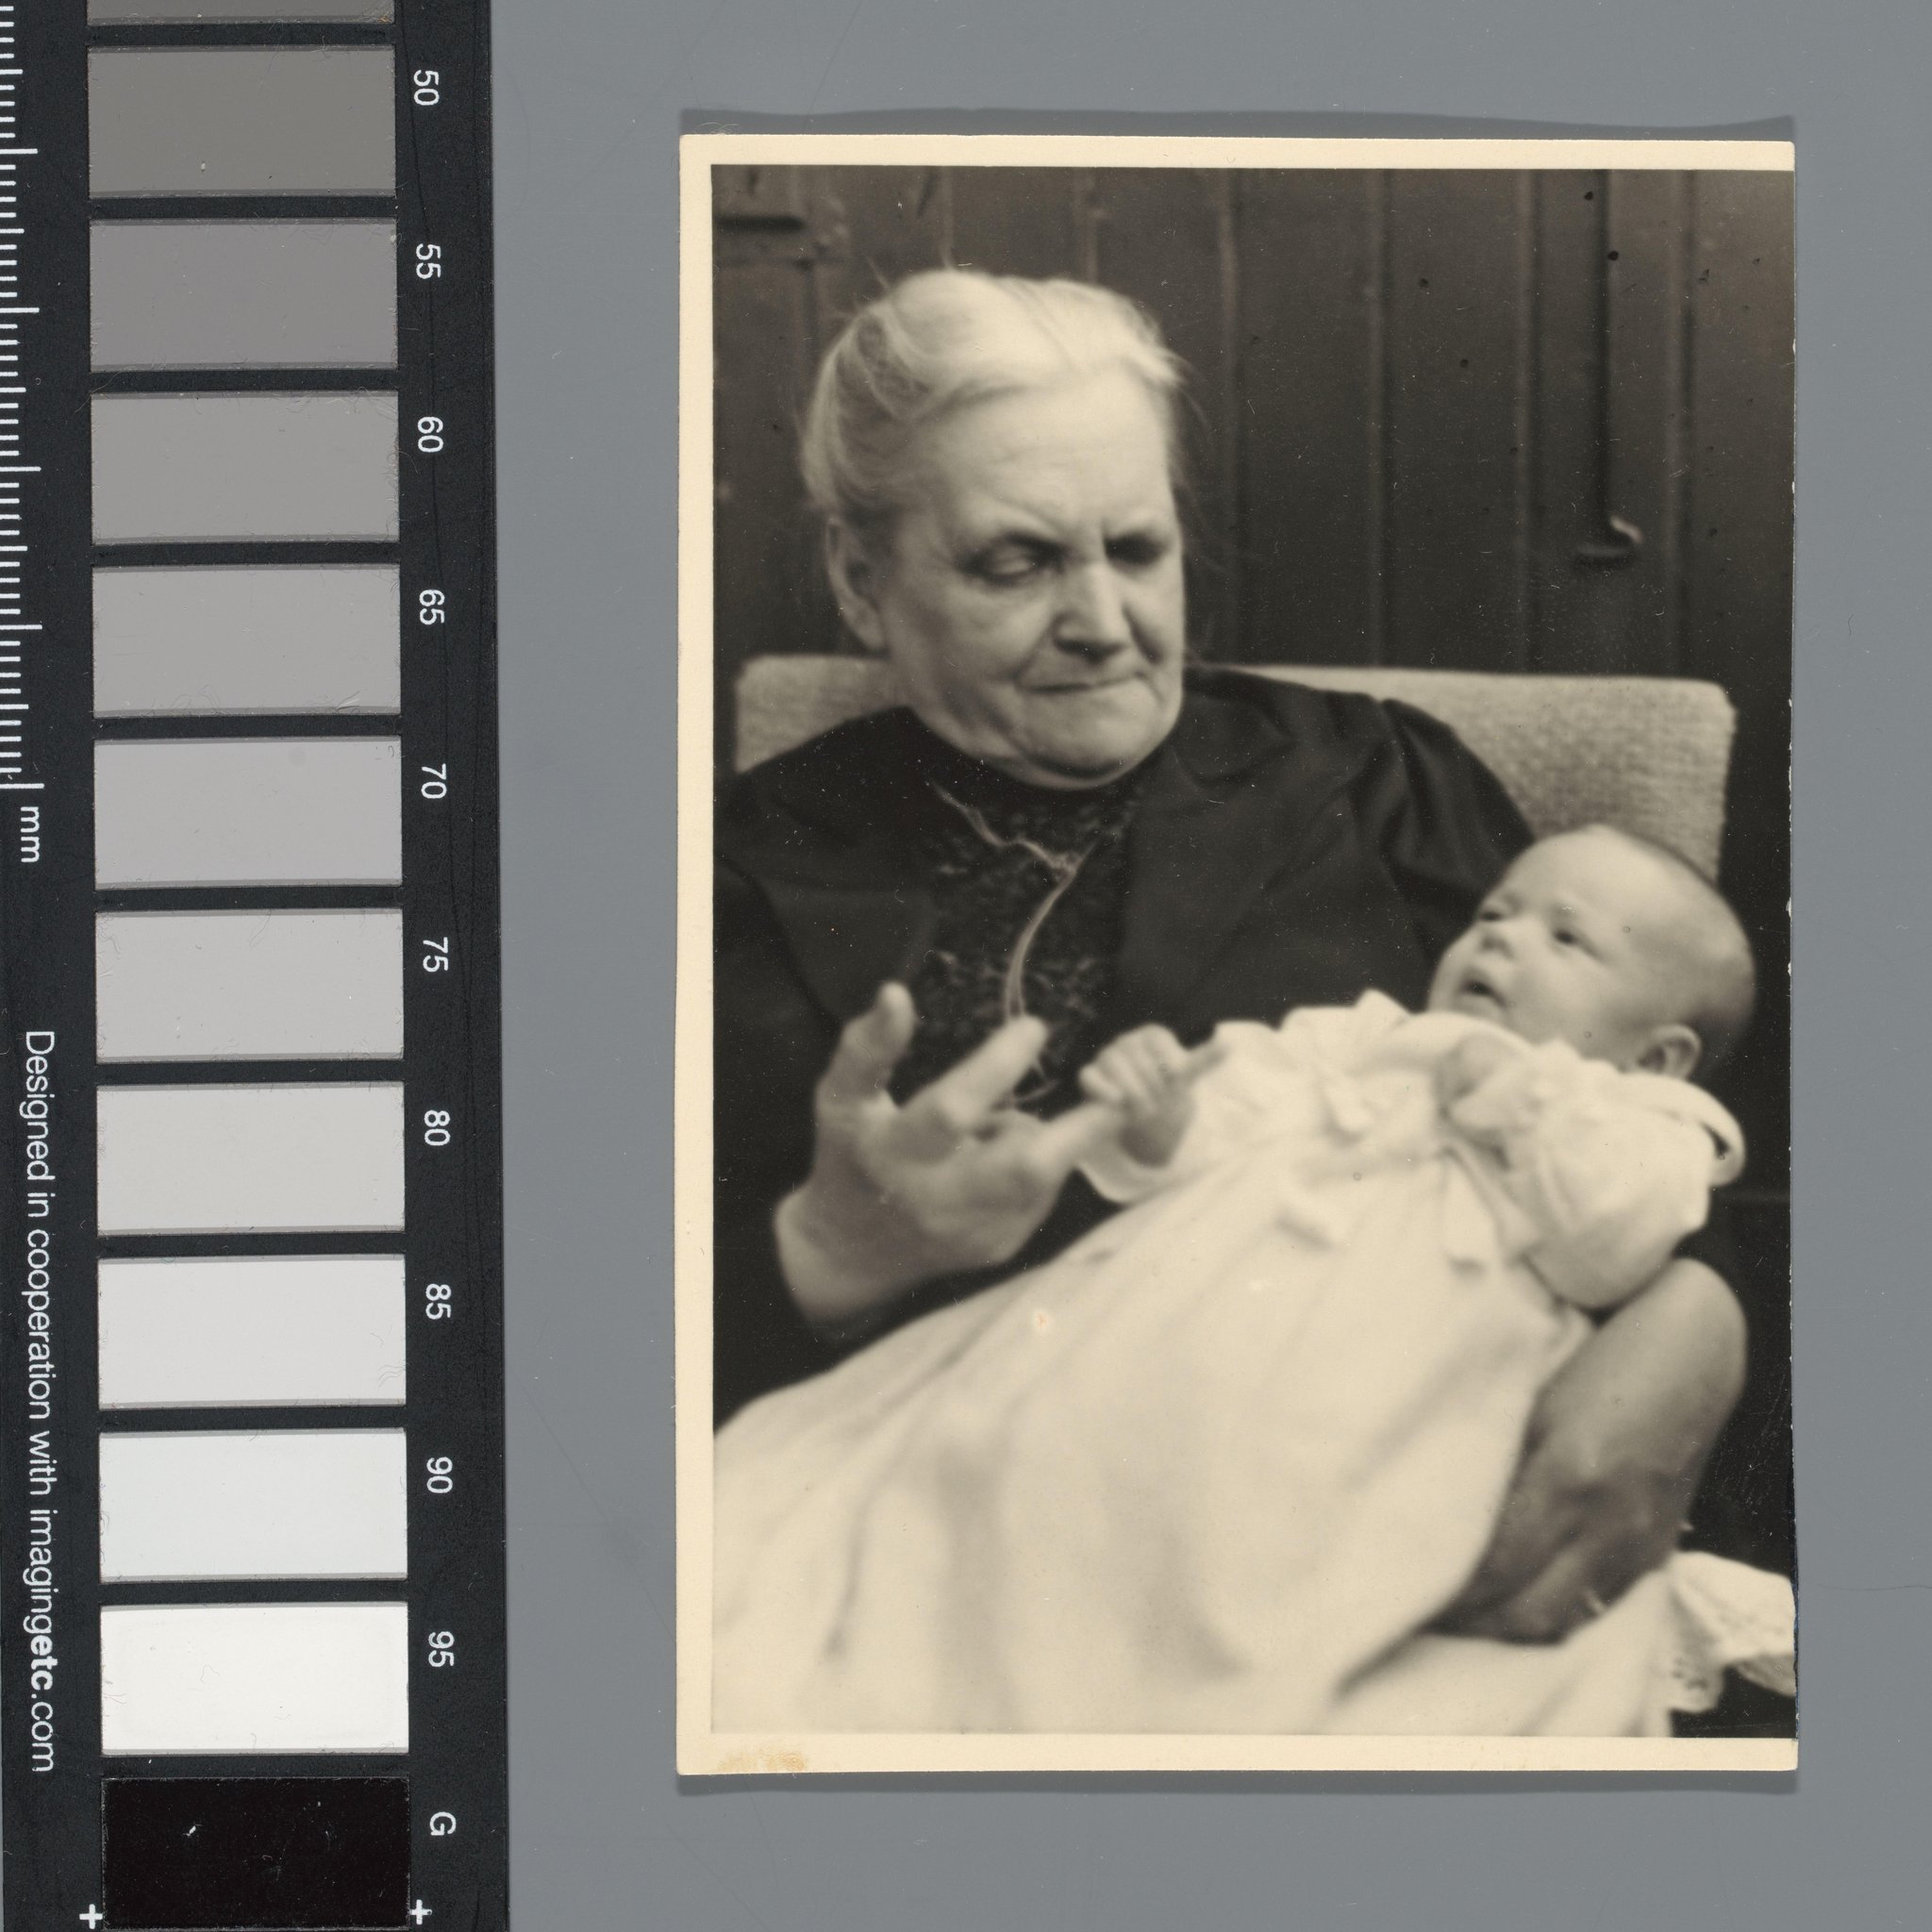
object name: photograph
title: Portret van Guusje van Roijen en een tante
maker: cornelia hendrika jonker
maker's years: 1874-1924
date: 1939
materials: photographic support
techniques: gelatin silver print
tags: historical persons - bb - woman, historical persons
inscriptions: date